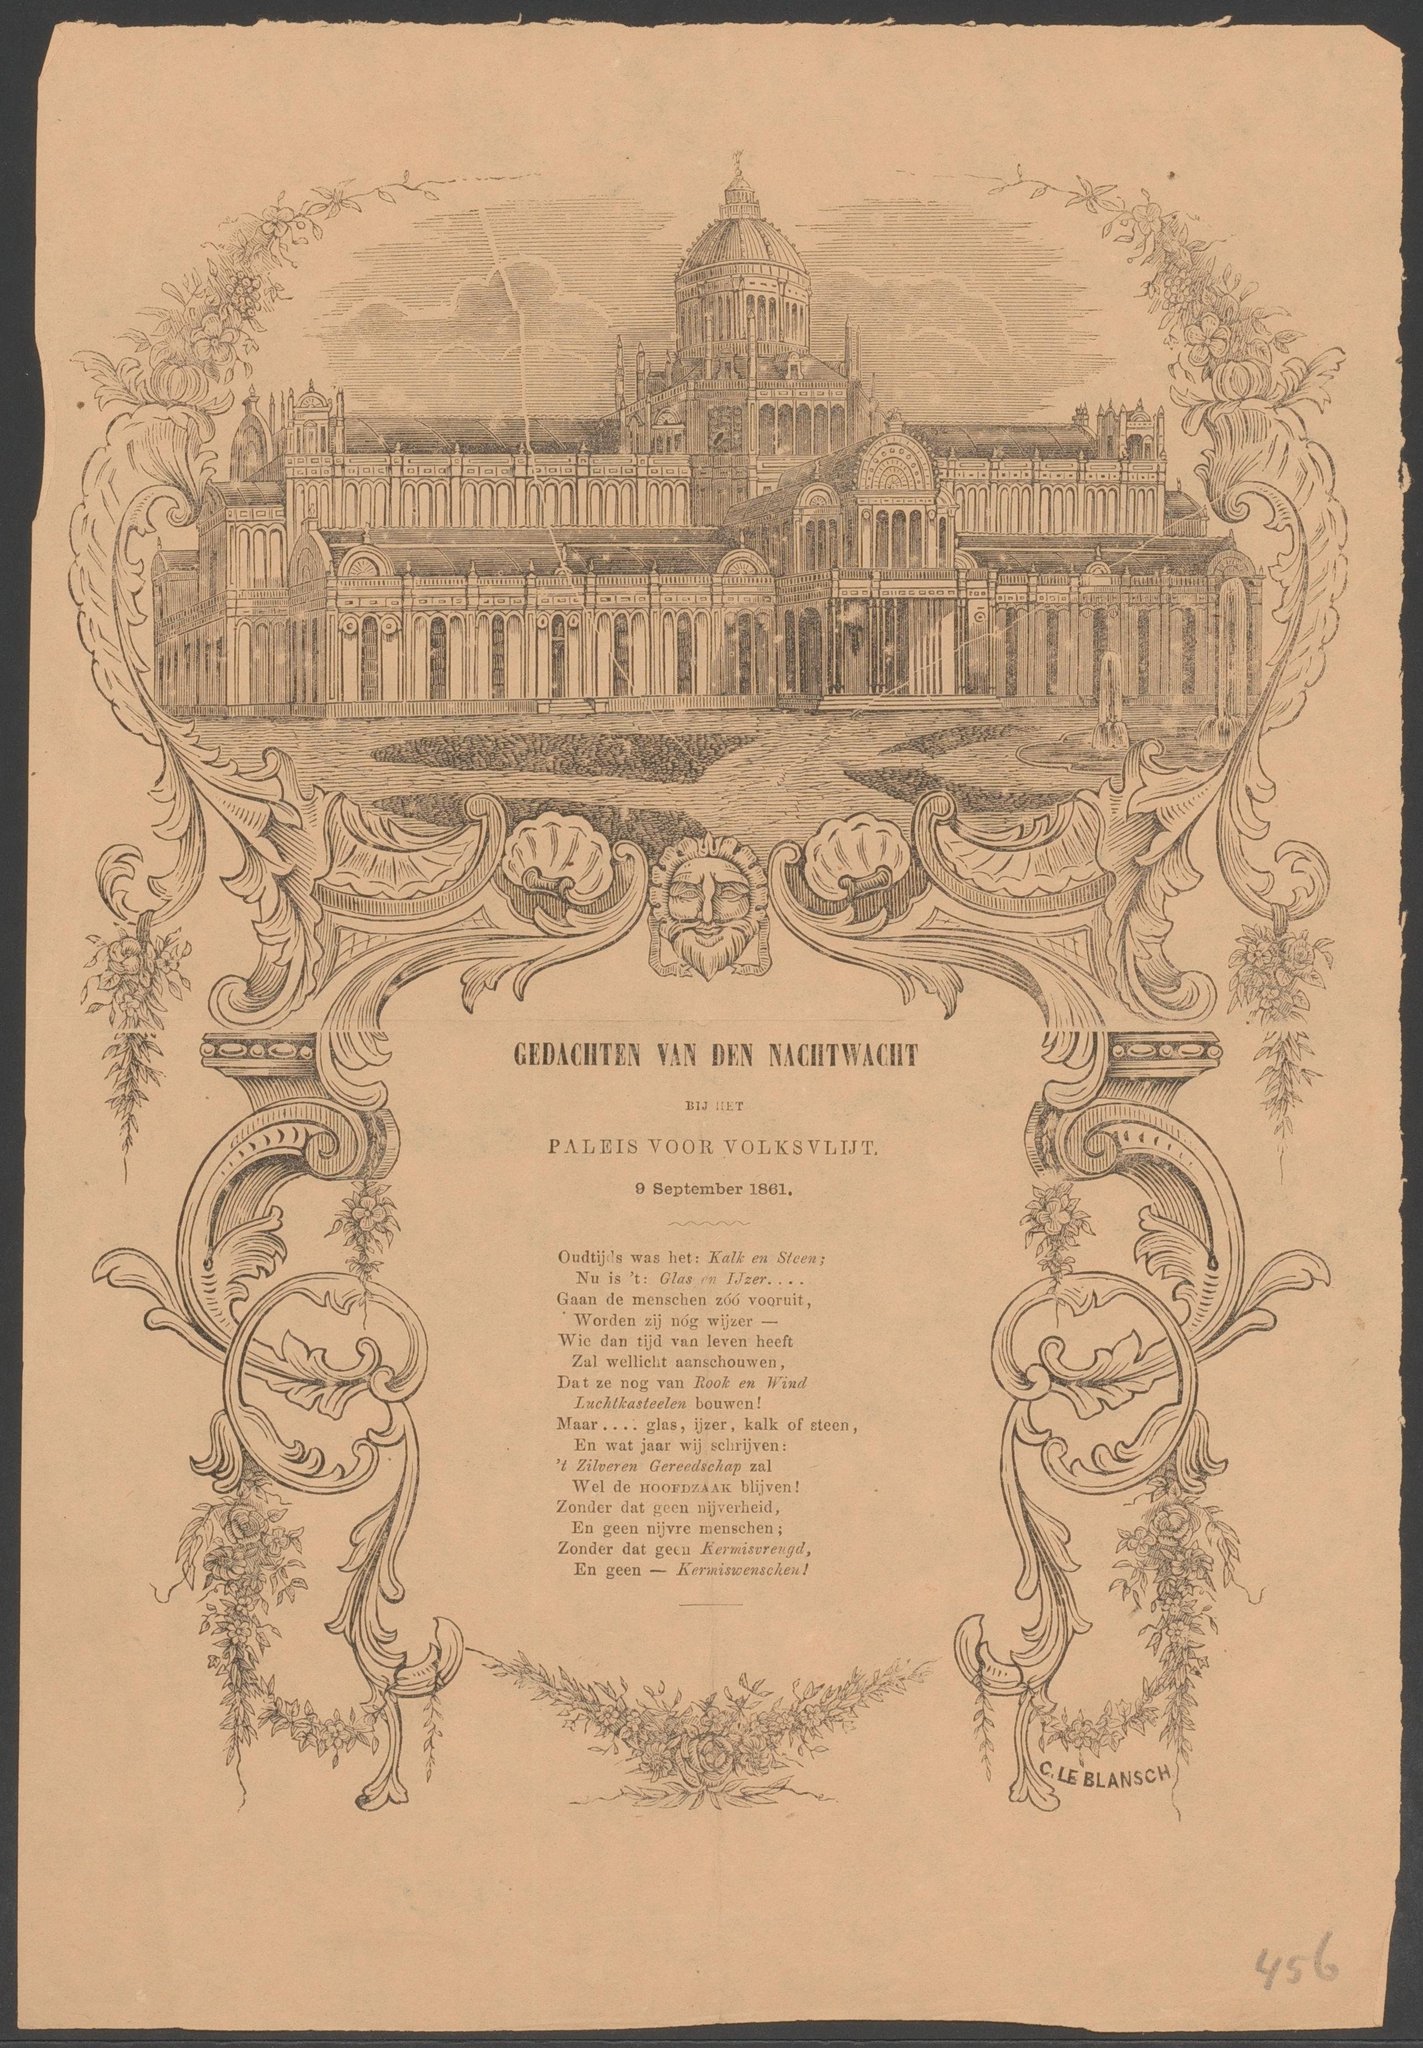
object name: print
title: Gedachten van den Nachtwacht bij het Paleis voor Volksvlijt. 9 september 1861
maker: christiaan le blansch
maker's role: print maker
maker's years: 1827-1886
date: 1861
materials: paper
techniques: letterpress printing, engraving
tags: night patrol, pleasure fair and circus, amsterdam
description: Kermisprent van de Amsterdamse nachtwacht (ratelwacht), 9 september 1861. Centraal een gedicht, daarboven het Paleis voor Volksvlijt te Amsterdam. Onderwerpsrubrieken binnen de Atlas Zeden en Gewoonten: Zeden en gewoonten in engeren zin, Volksleven, Volksbladen, Nieuwjaars- en Kerstwenschen, Amsterdam.